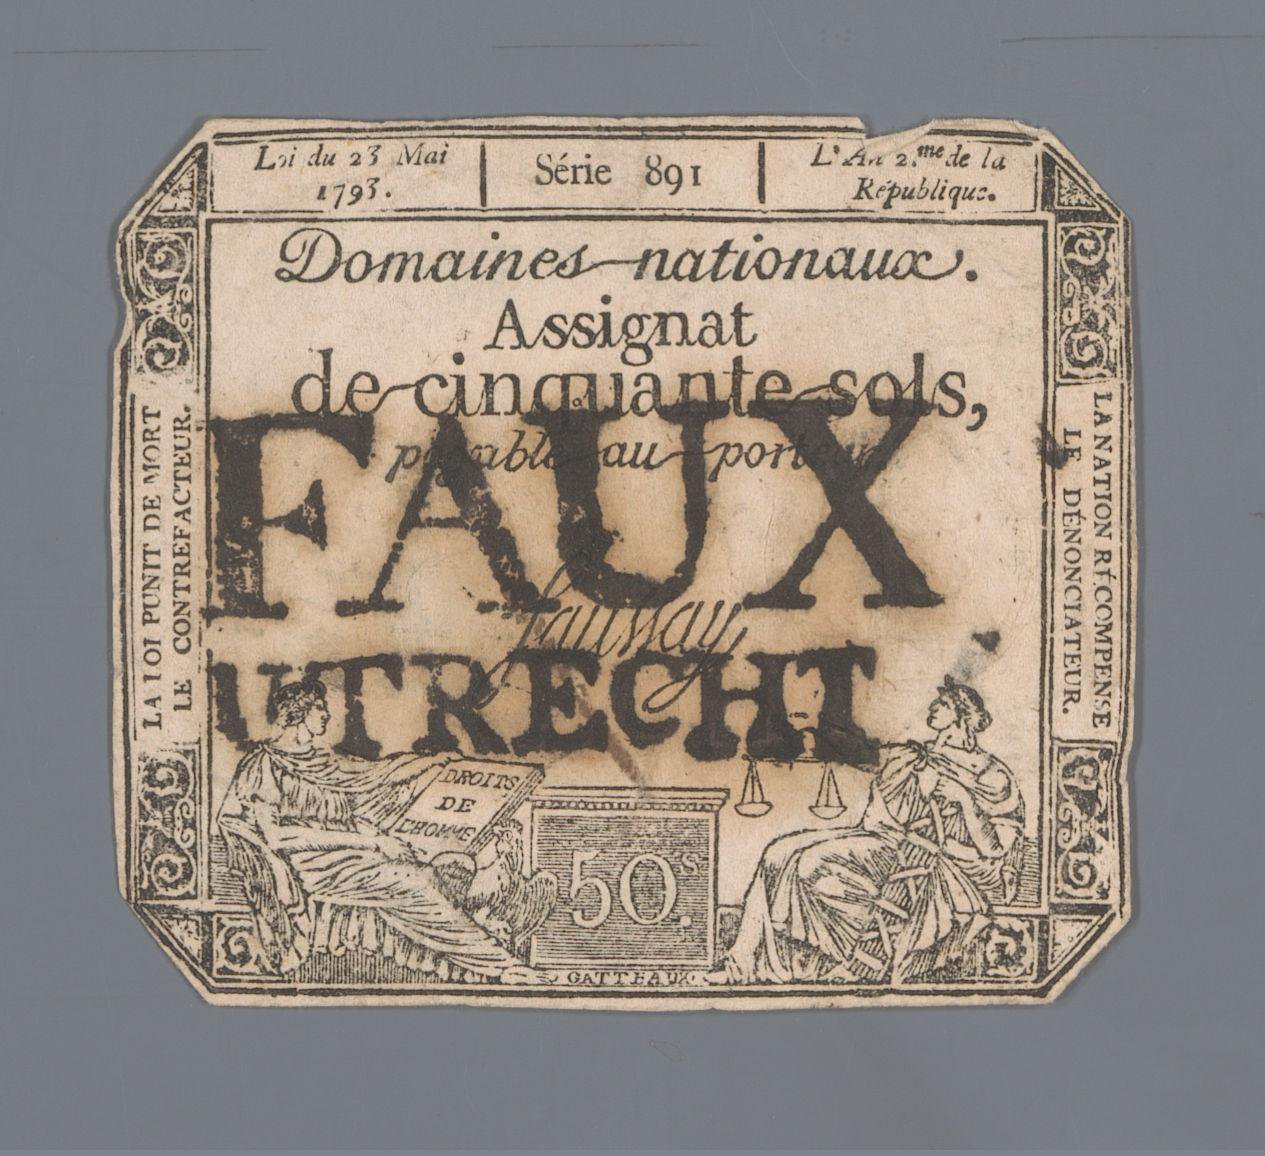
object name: assignat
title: Te Utrecht ongeldig gemaakte assignat van vijftig sols, serie 891, uitgegeven 23 mei 1793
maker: nicolas marie gatteaux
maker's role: medailleur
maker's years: 1751-1832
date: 1793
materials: paper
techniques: printing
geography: france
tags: utrecht, france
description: Eenzijdig bedrukte papiertje, assignaat van 50 sols. Onder: twee zittende figuren. Serie 891. Gemerkt; m.: stempel: 'Faux Utrecht'. Gesigneerd.